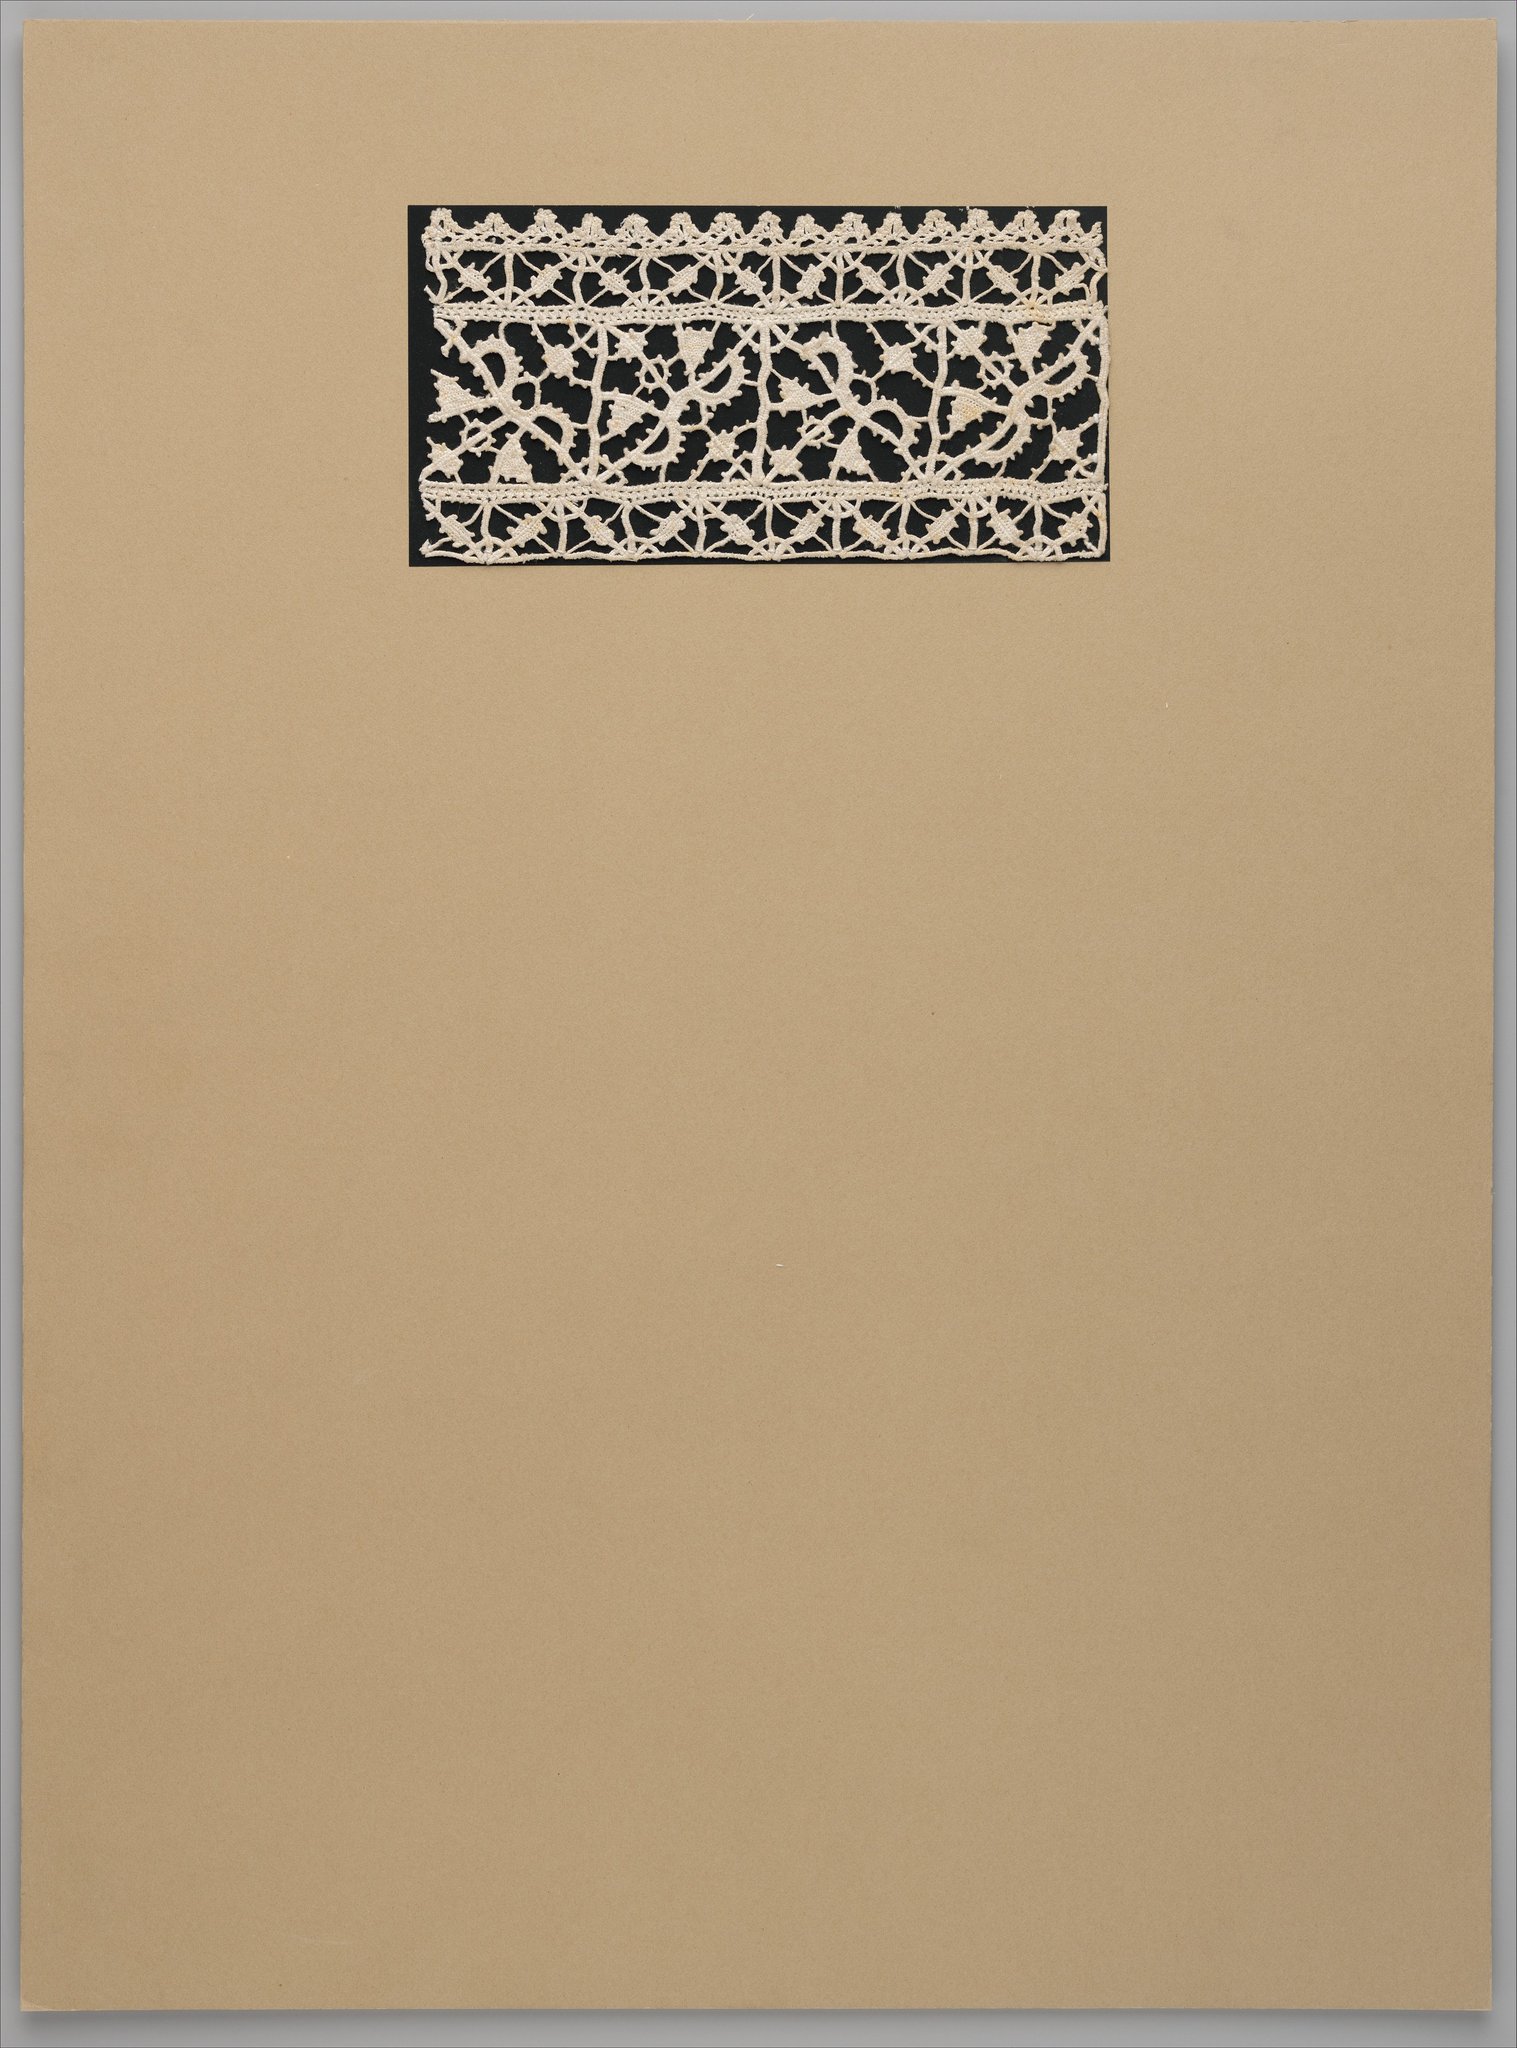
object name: insertion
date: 1501-1700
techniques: lace